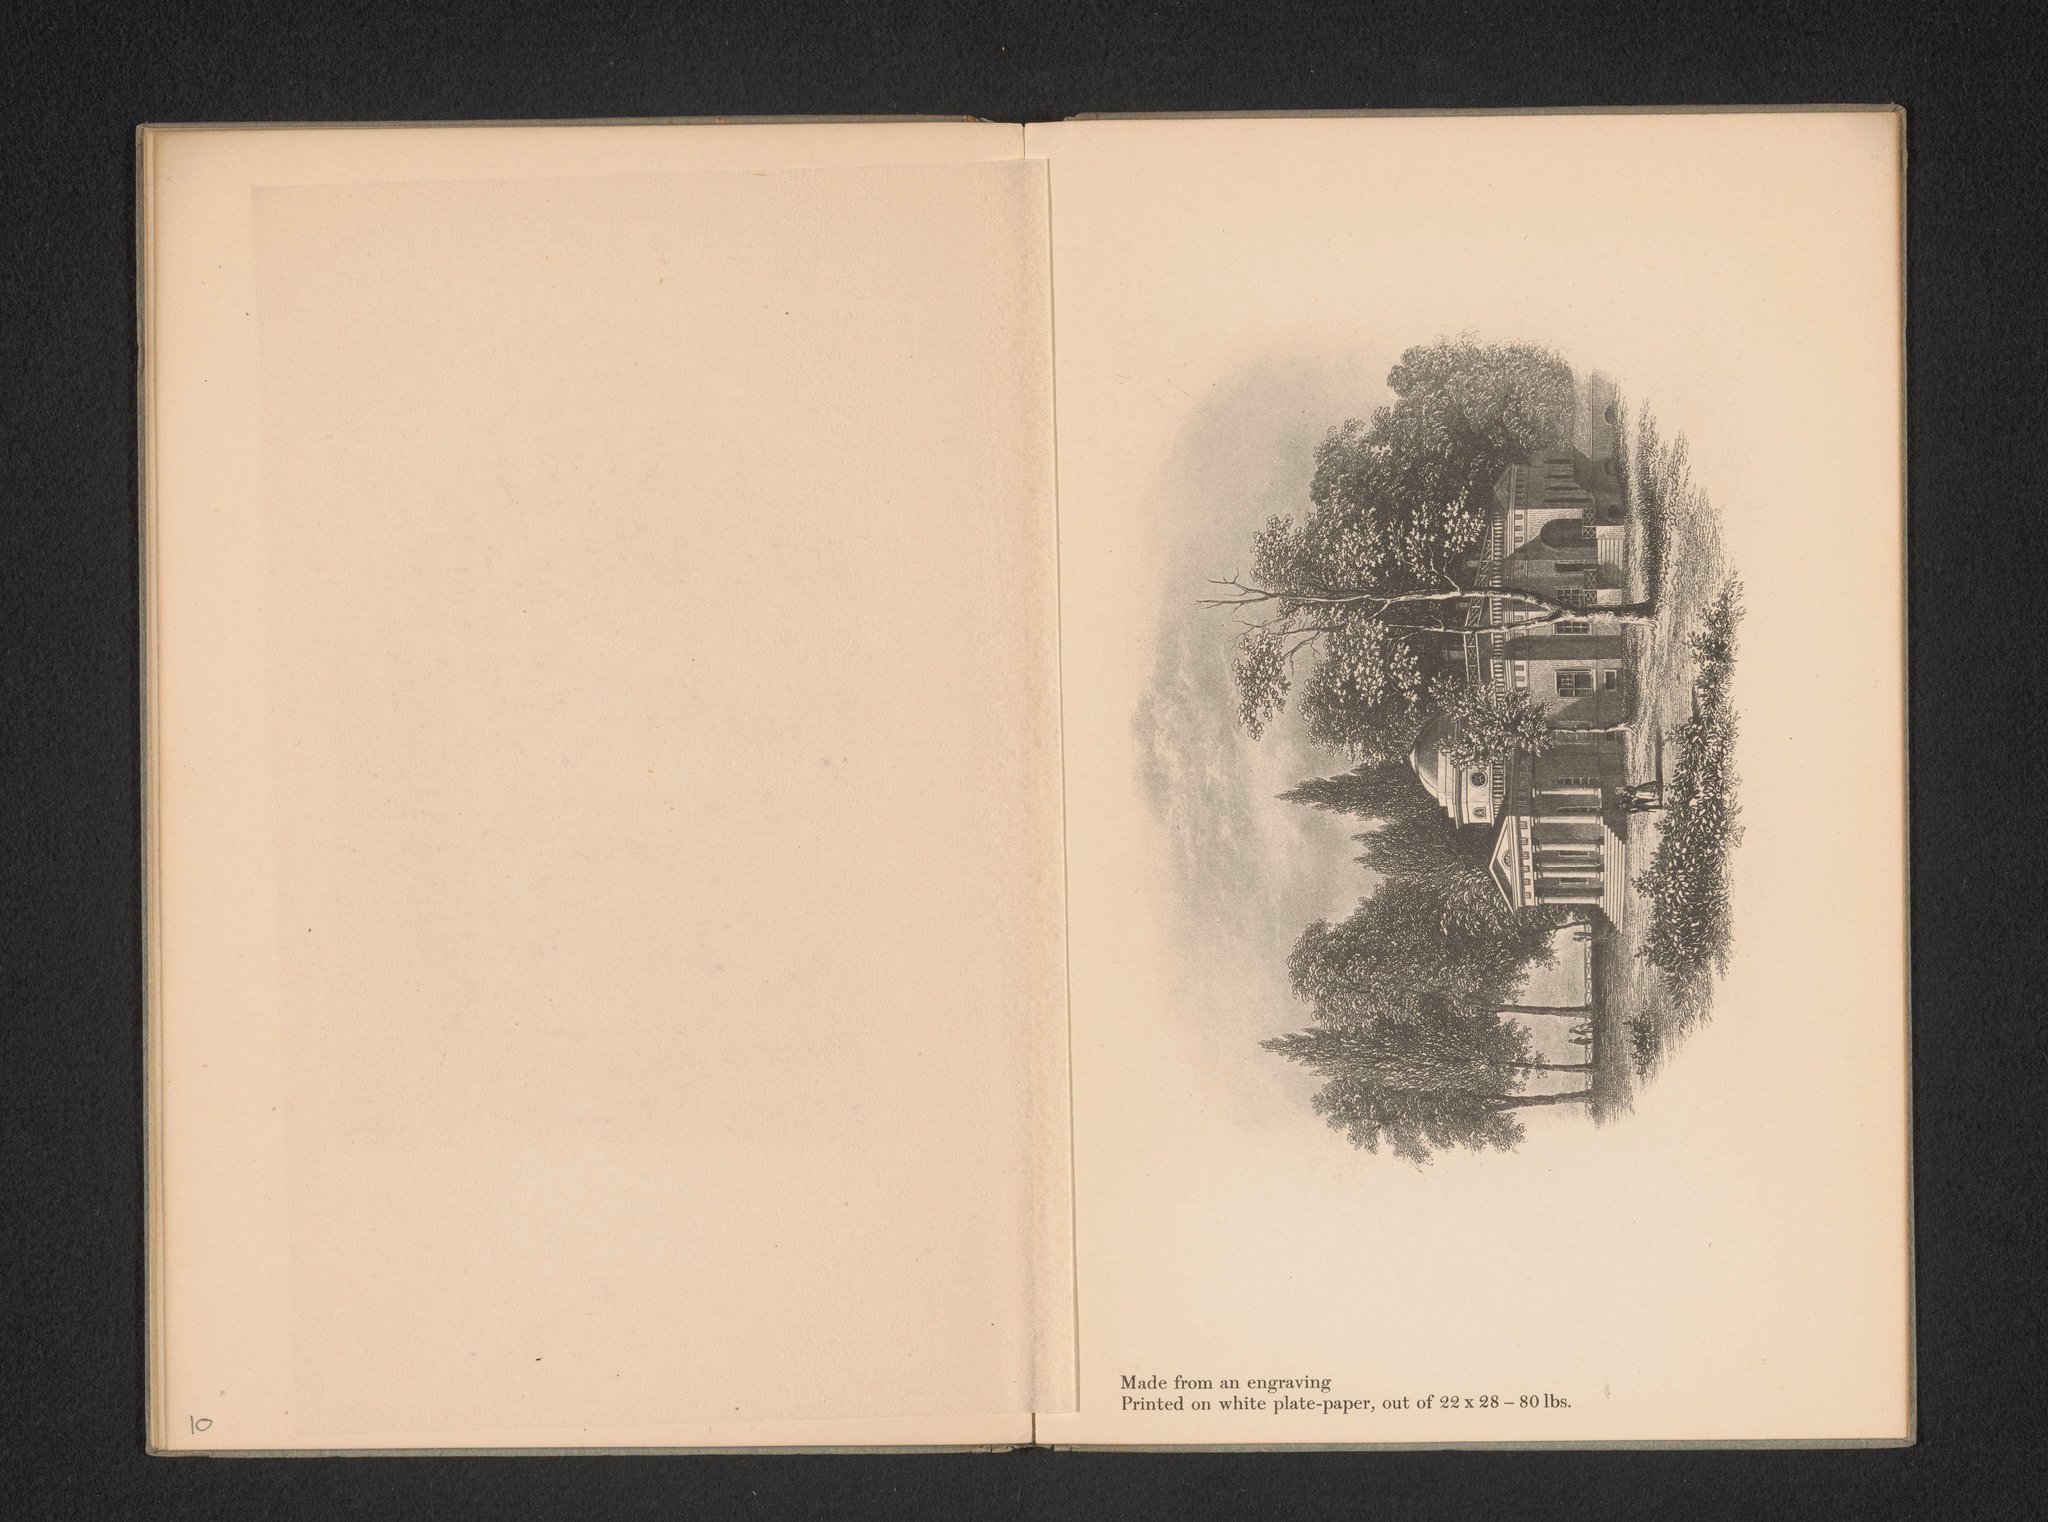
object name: reproduction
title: Reproductie van een gravure van een landschap met een gebouw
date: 1903-1908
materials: paper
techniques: photograph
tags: landscapes, façade (of house or building)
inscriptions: inscription: ‘Made from an engraving/ Printed on whtie plate-paper, out of 22 x 28 - 80 lbs.’